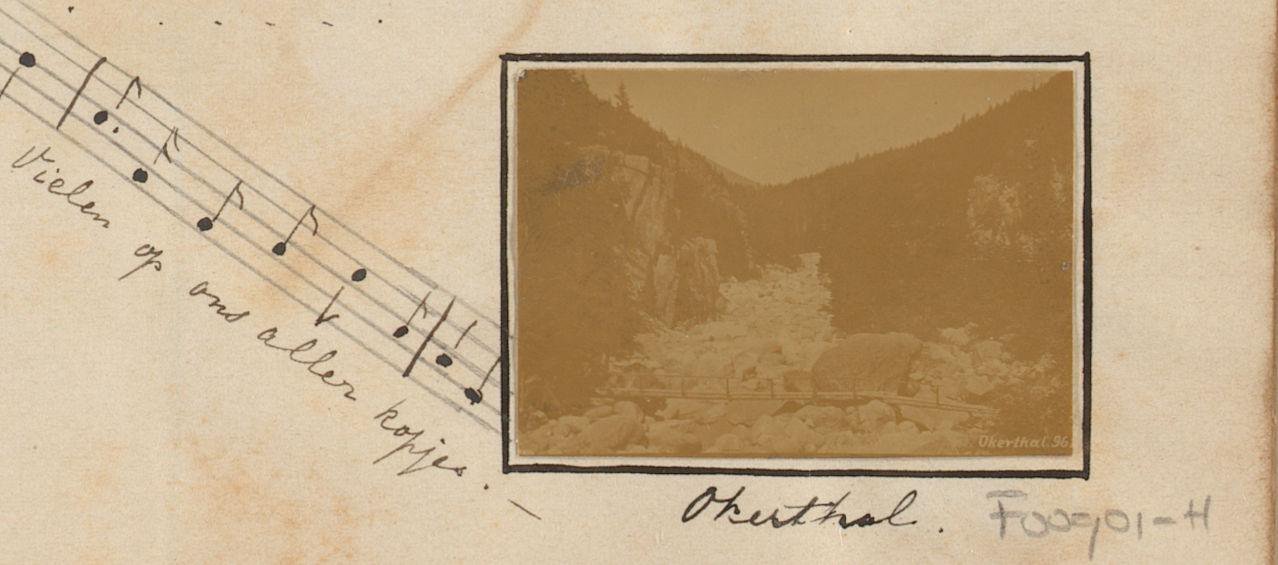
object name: photograph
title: Gezicht op Oberthal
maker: Anonymous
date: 1885-1891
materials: ink, photographic support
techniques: albumen print, pen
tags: trees, landscapes with waters, waterscapes, seascapes (in the temperate zone), germany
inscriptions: annotation: ‘De natte [...]/ [...]/ (...)’, annotation: ‘Obertal’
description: Deze foto maakt deel uit van een album. Om de foto heen is een notenbalk getekend.